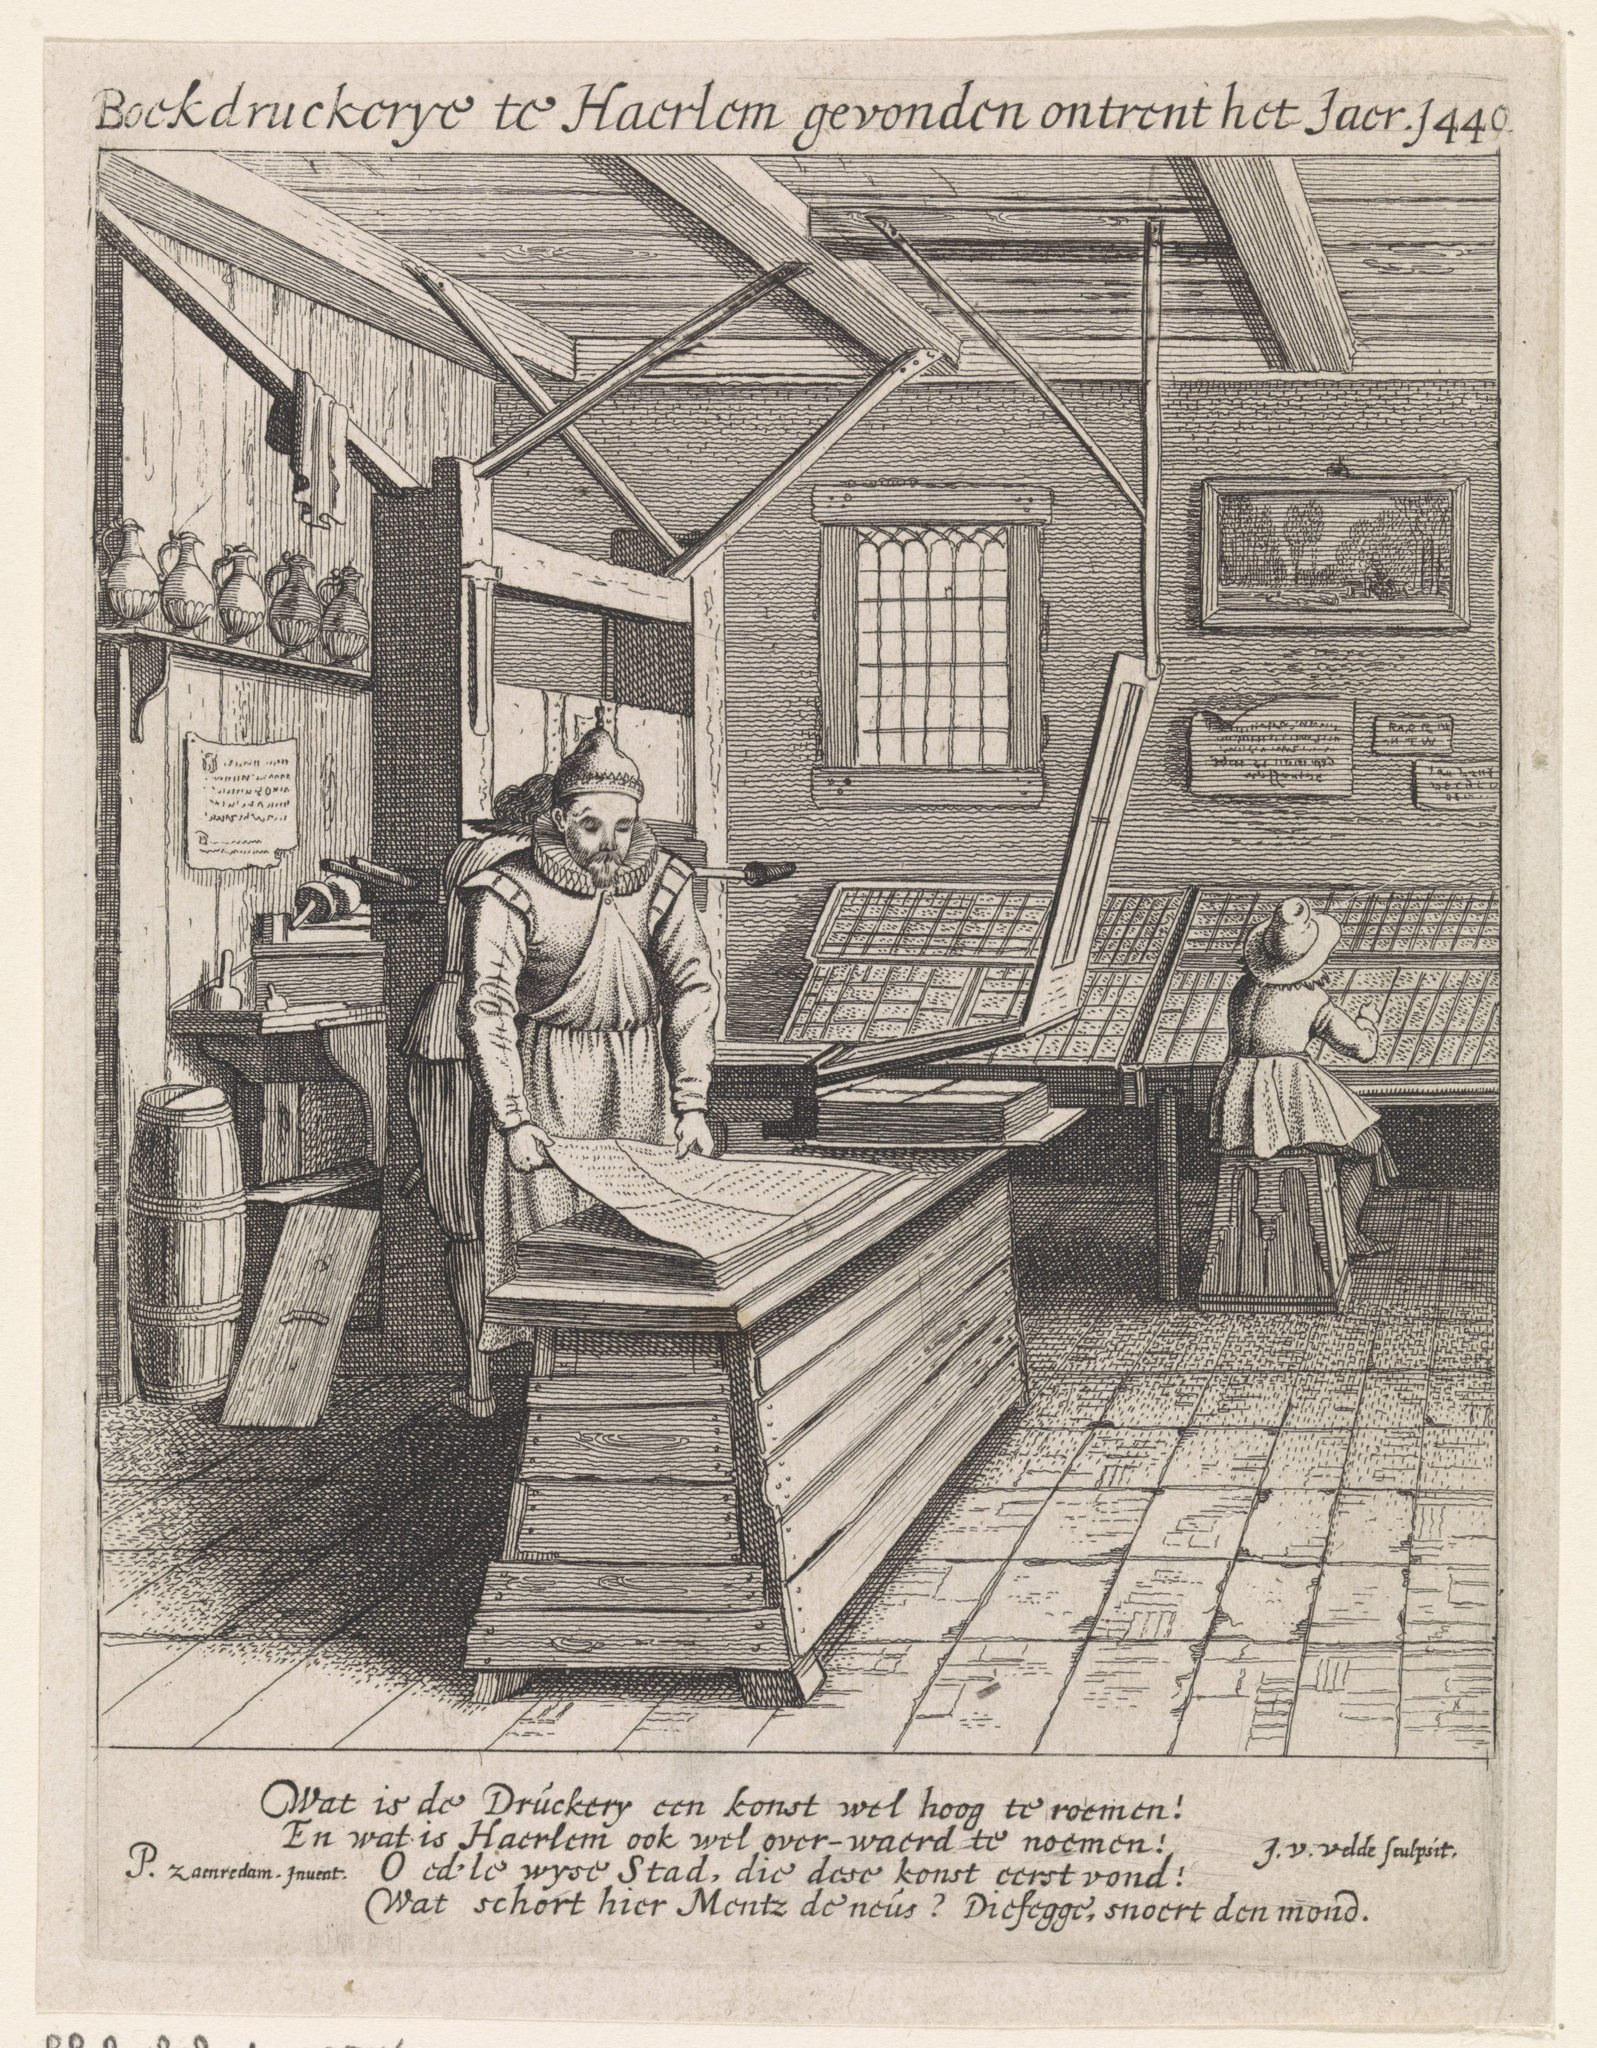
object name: history print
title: Interieur van een boekdrukkerij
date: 1628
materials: paper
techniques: etching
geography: haarlem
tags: haarlem, printing, printing office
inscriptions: collector's mark: Lugt 964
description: Uitvinding van de boekdrukkunst te Haarlem, ca. 1440. Interieur van een boekdrukkerij, met het leggen van papier en verzamelen van drukletters.